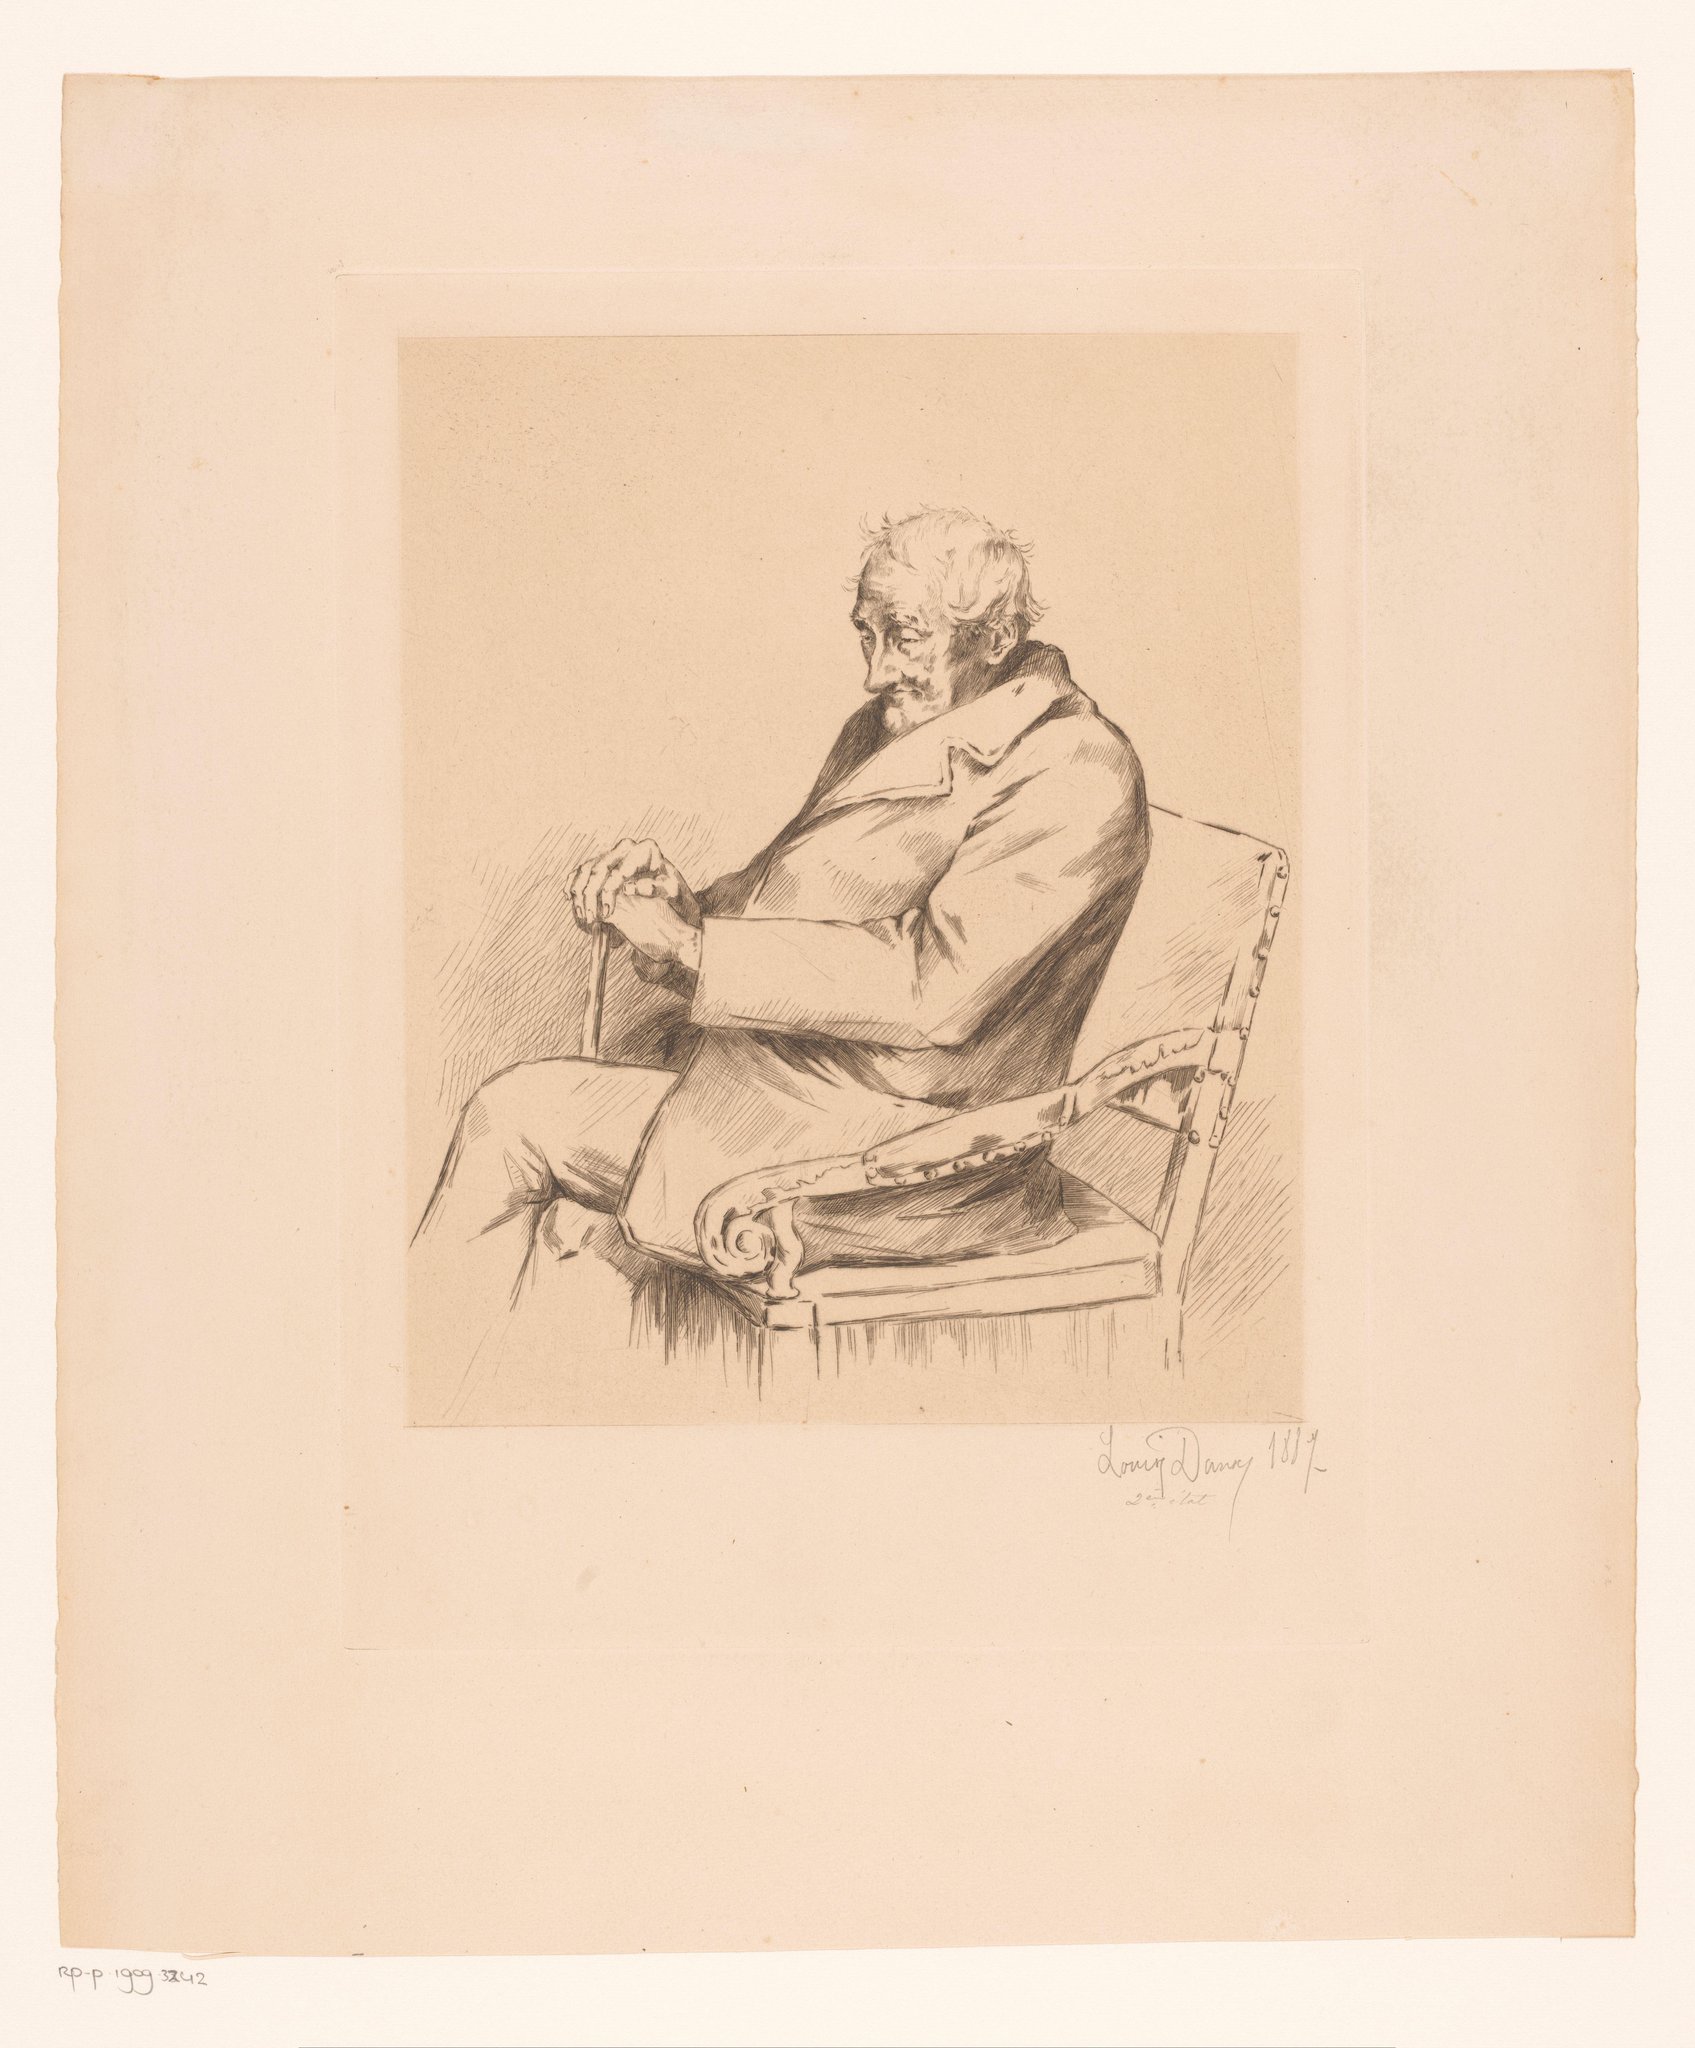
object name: print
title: Oude man met een wandelstok in een stoel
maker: louise danse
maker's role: painter, print maker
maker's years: 1867-1948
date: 1887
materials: paper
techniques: drypoint, etching, intaglio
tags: anonymous historical person portrayed alone, old man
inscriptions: collector's mark: Lugt 2228, annotation: ‘2ème état’